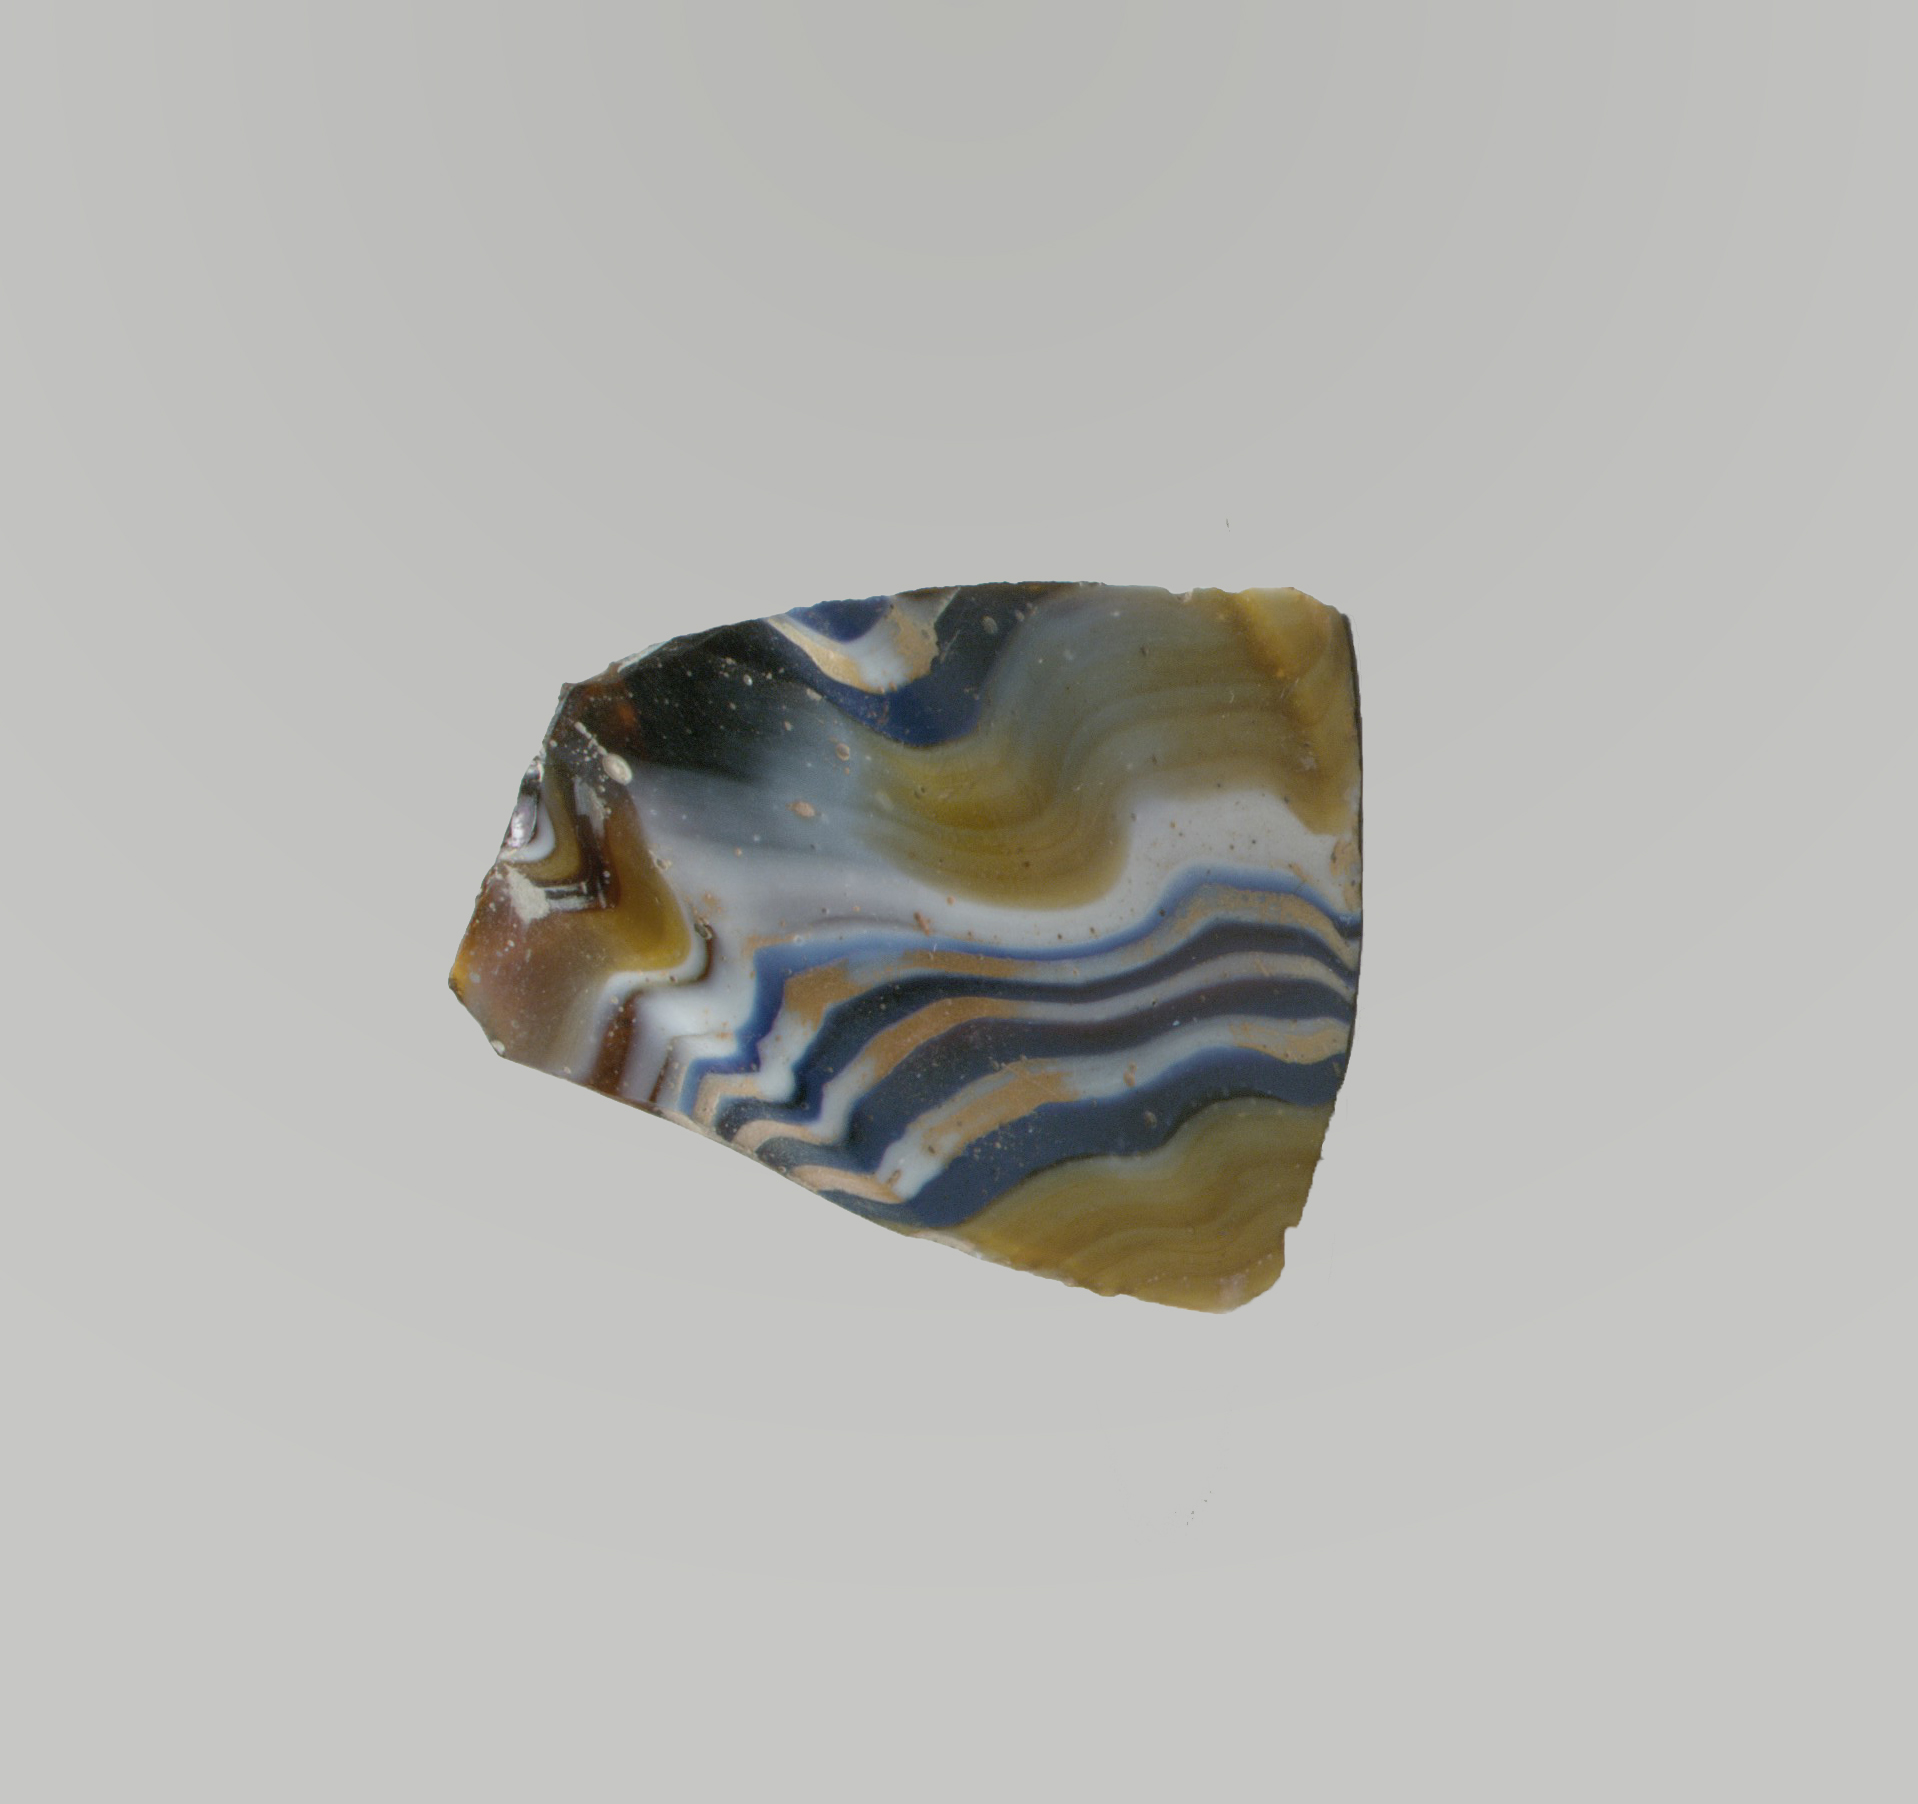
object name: fragment, mosaic bowl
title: Glass mosaic ribbed bowl fragment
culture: roman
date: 34 BCE-33 CE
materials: glass